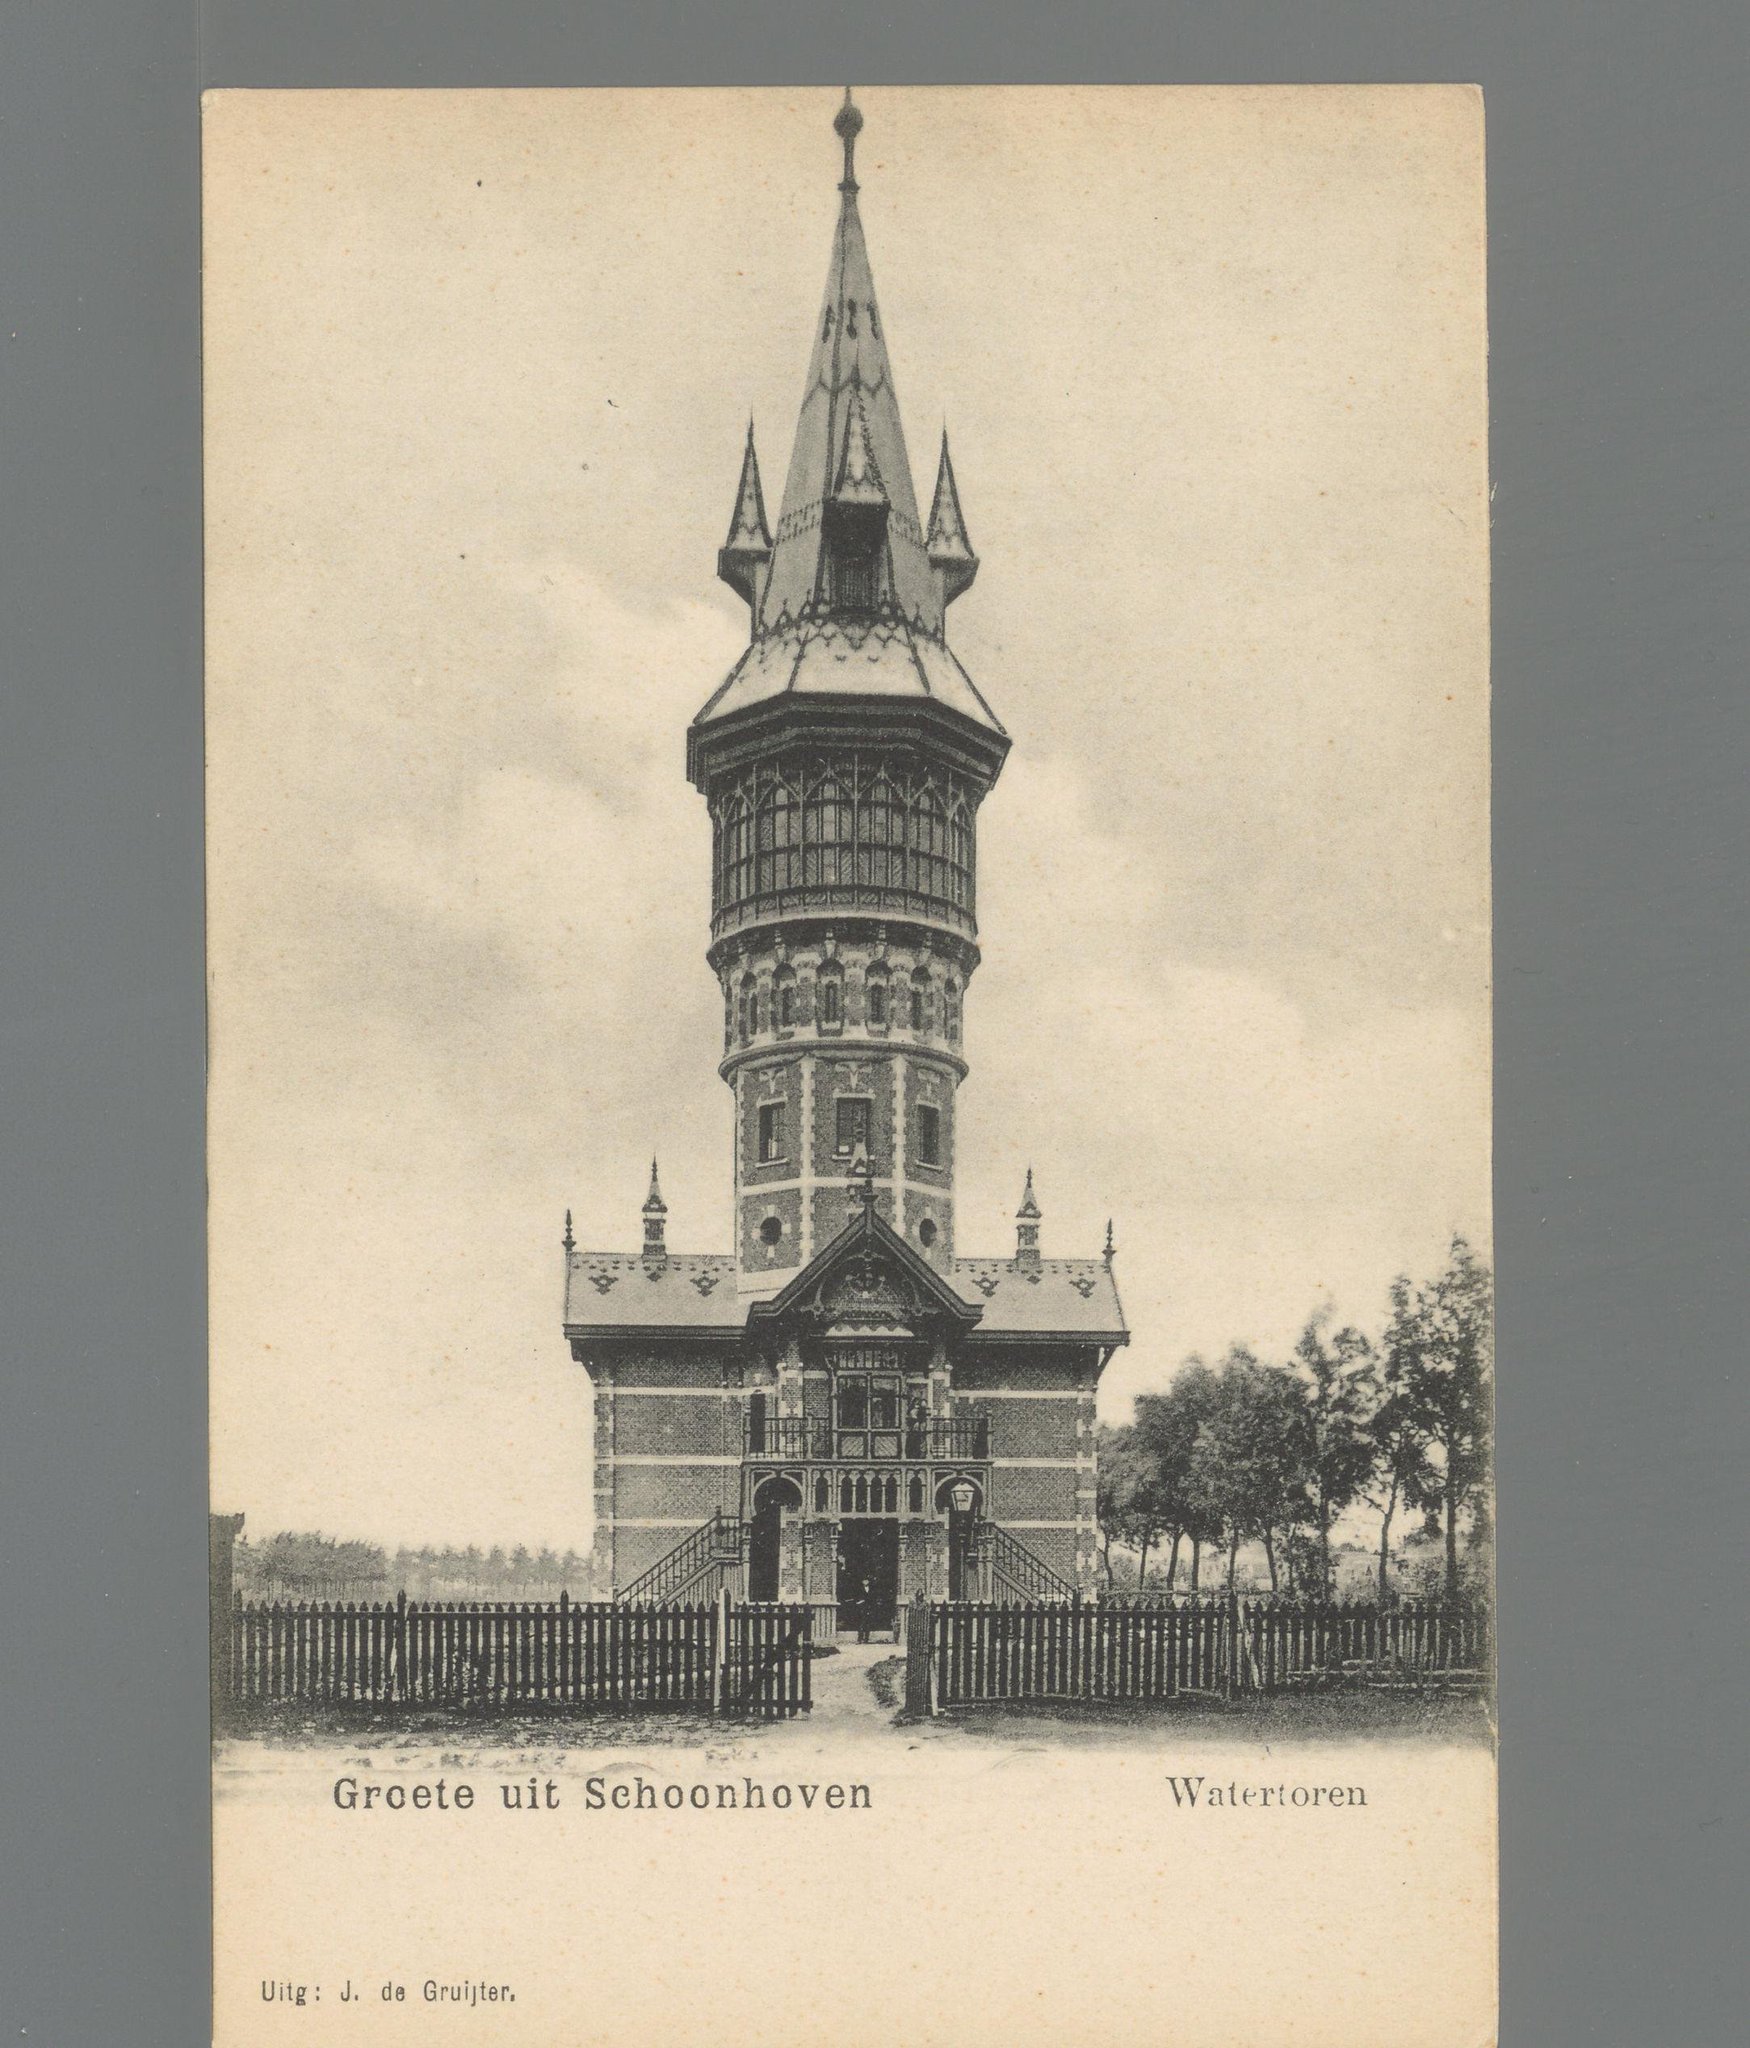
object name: ansichtkaart, prentbriefkaart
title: Groete uit Schoonhoven. Watertoren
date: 1901-1905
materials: cardboard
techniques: photograph, writing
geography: schoonhoven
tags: water tower